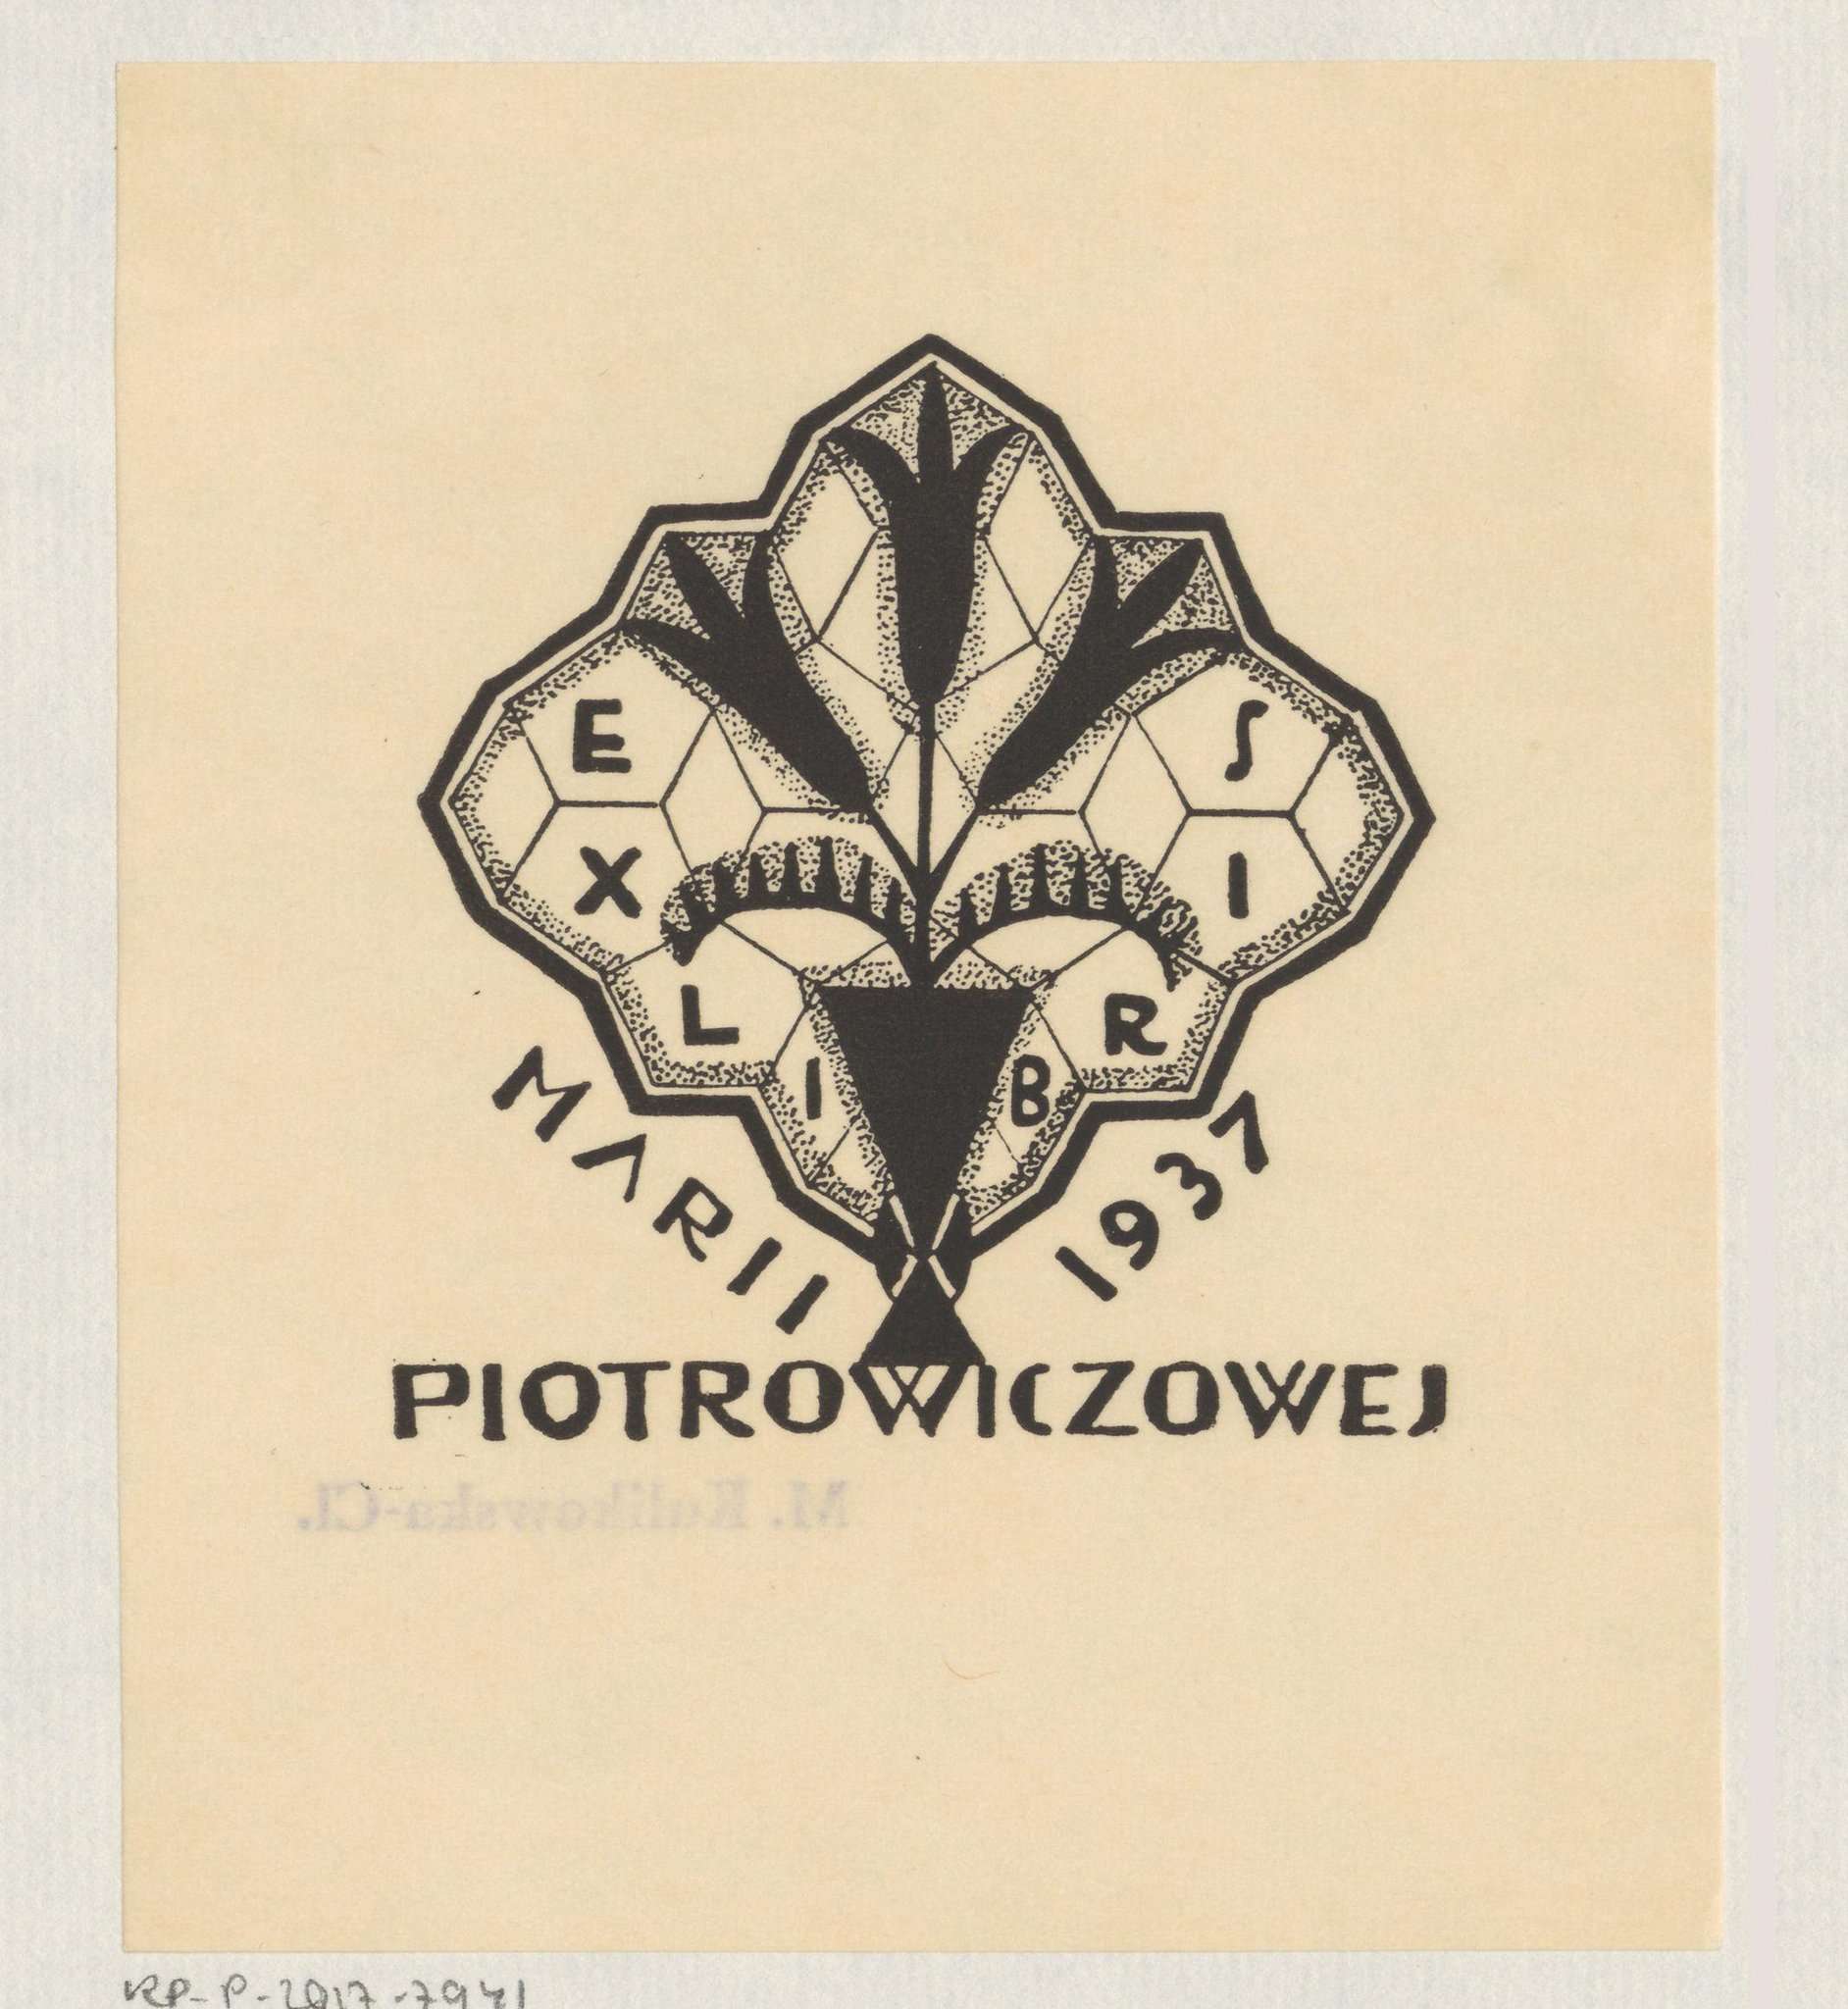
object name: bookplate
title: Ex libris Marii Piotrowiczowej 1937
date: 1937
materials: paper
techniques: printing block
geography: poland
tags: plants and herbs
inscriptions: workshop stamp: ‘M. Kulikowska-Cl.’